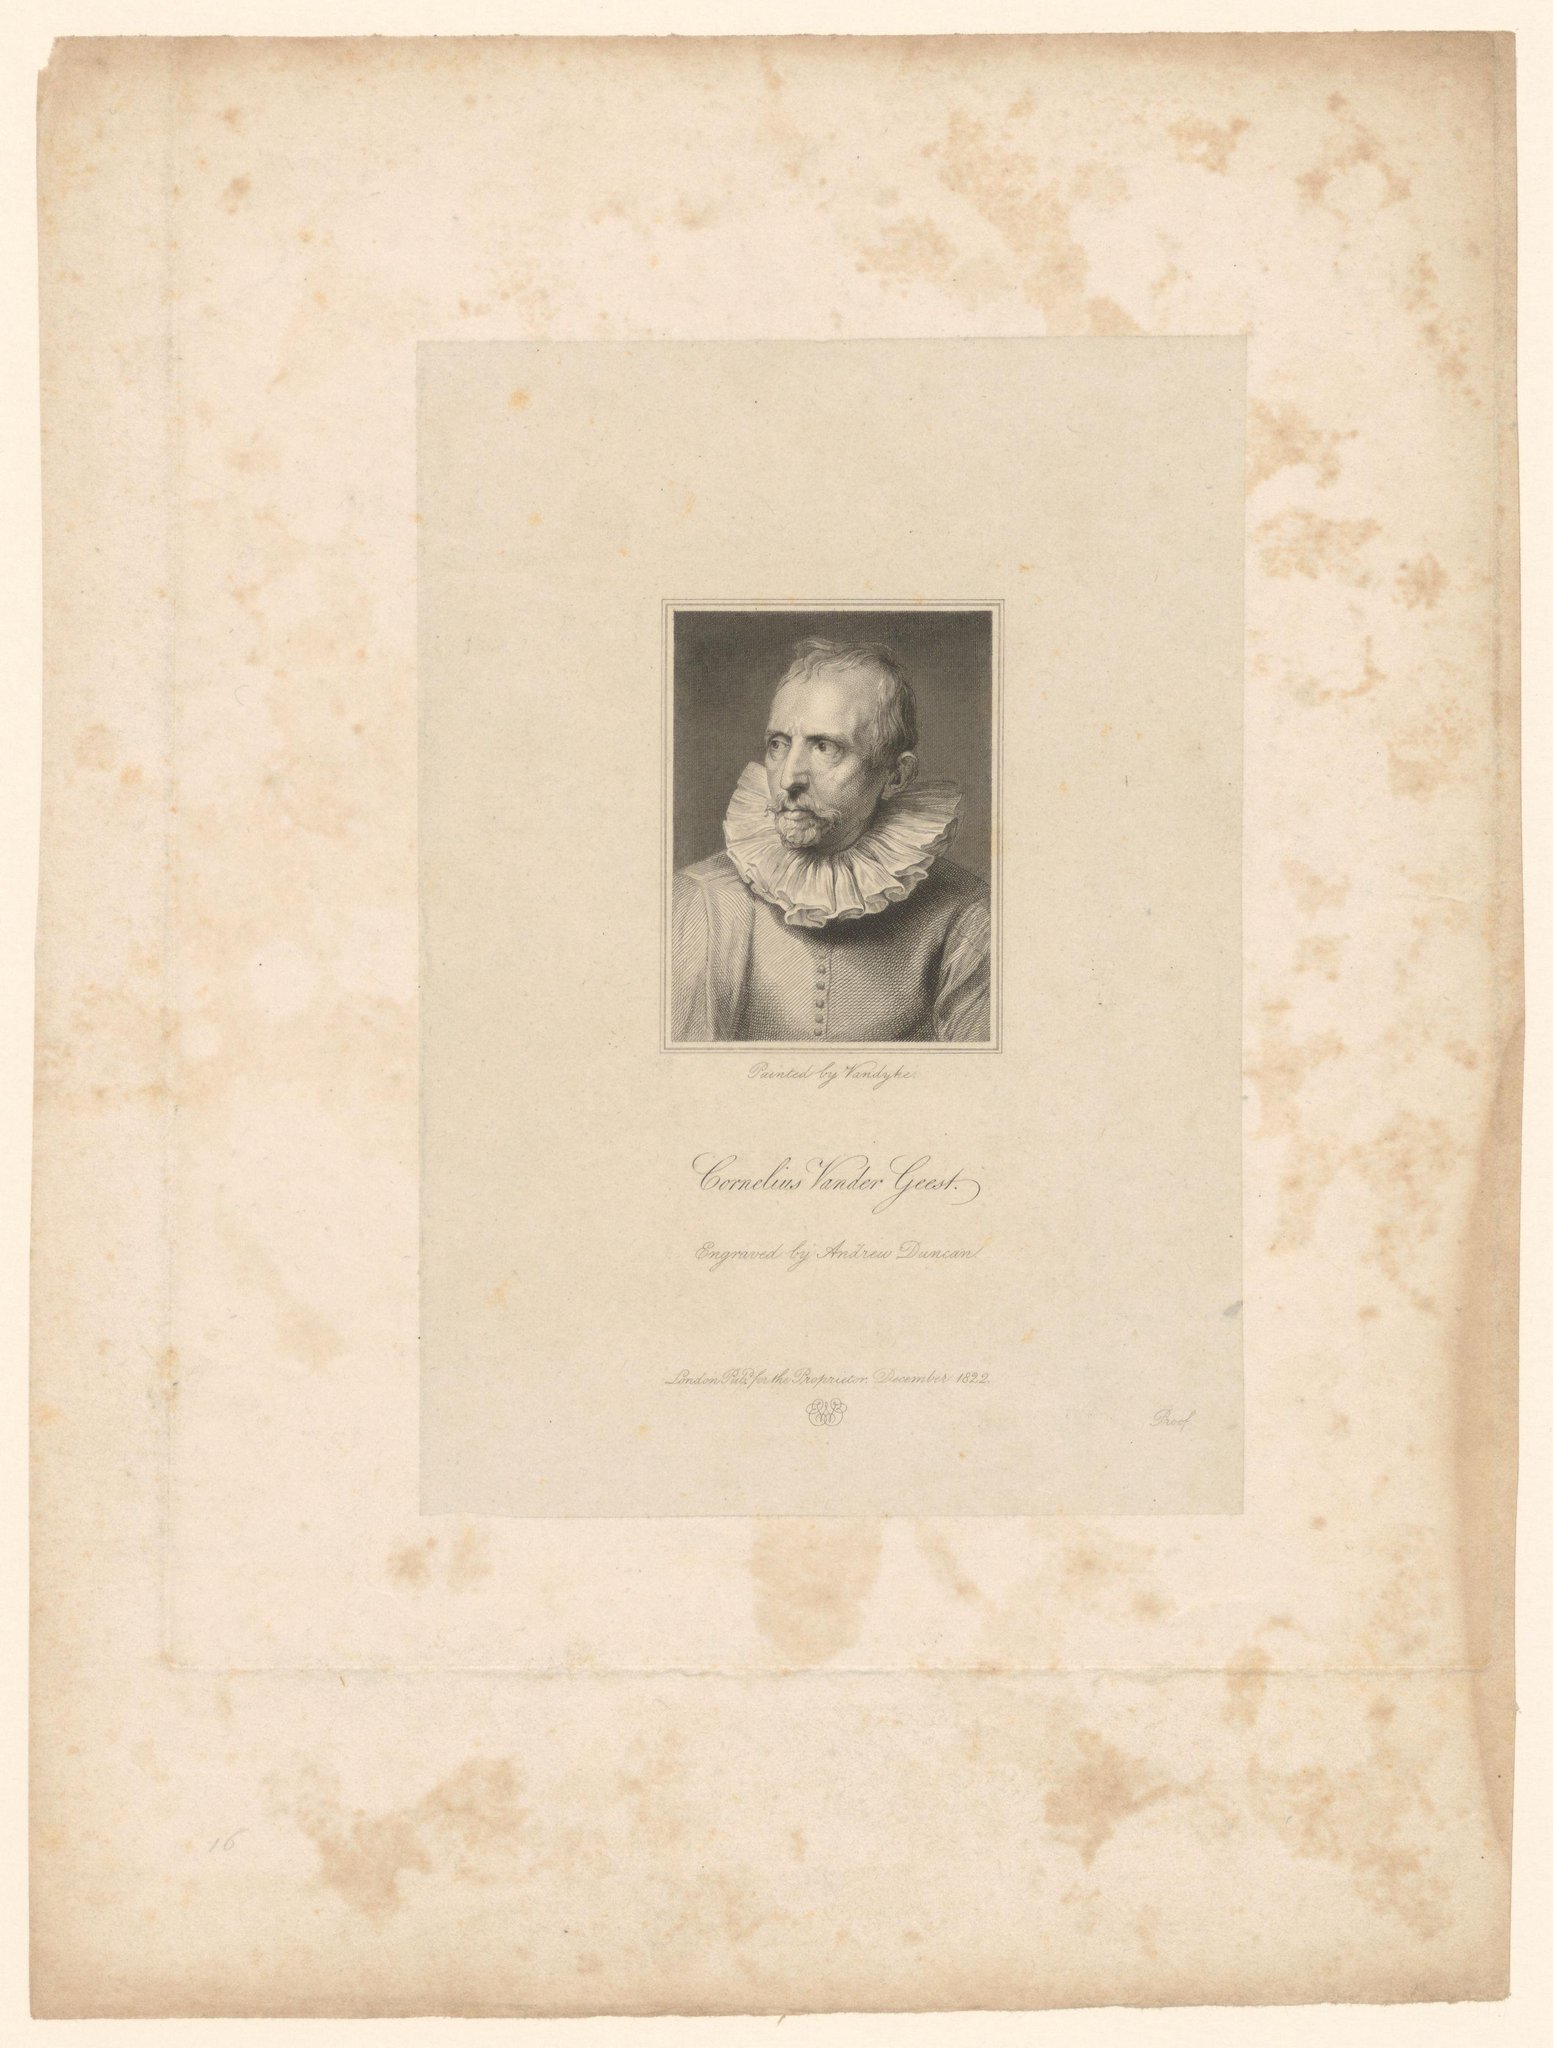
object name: print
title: Portret van Cornelis van der Geest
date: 1812-1822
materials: paper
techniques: engraving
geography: london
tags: cornelis van der geest, historical persons, art collector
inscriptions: collector's mark: Lugt 2228